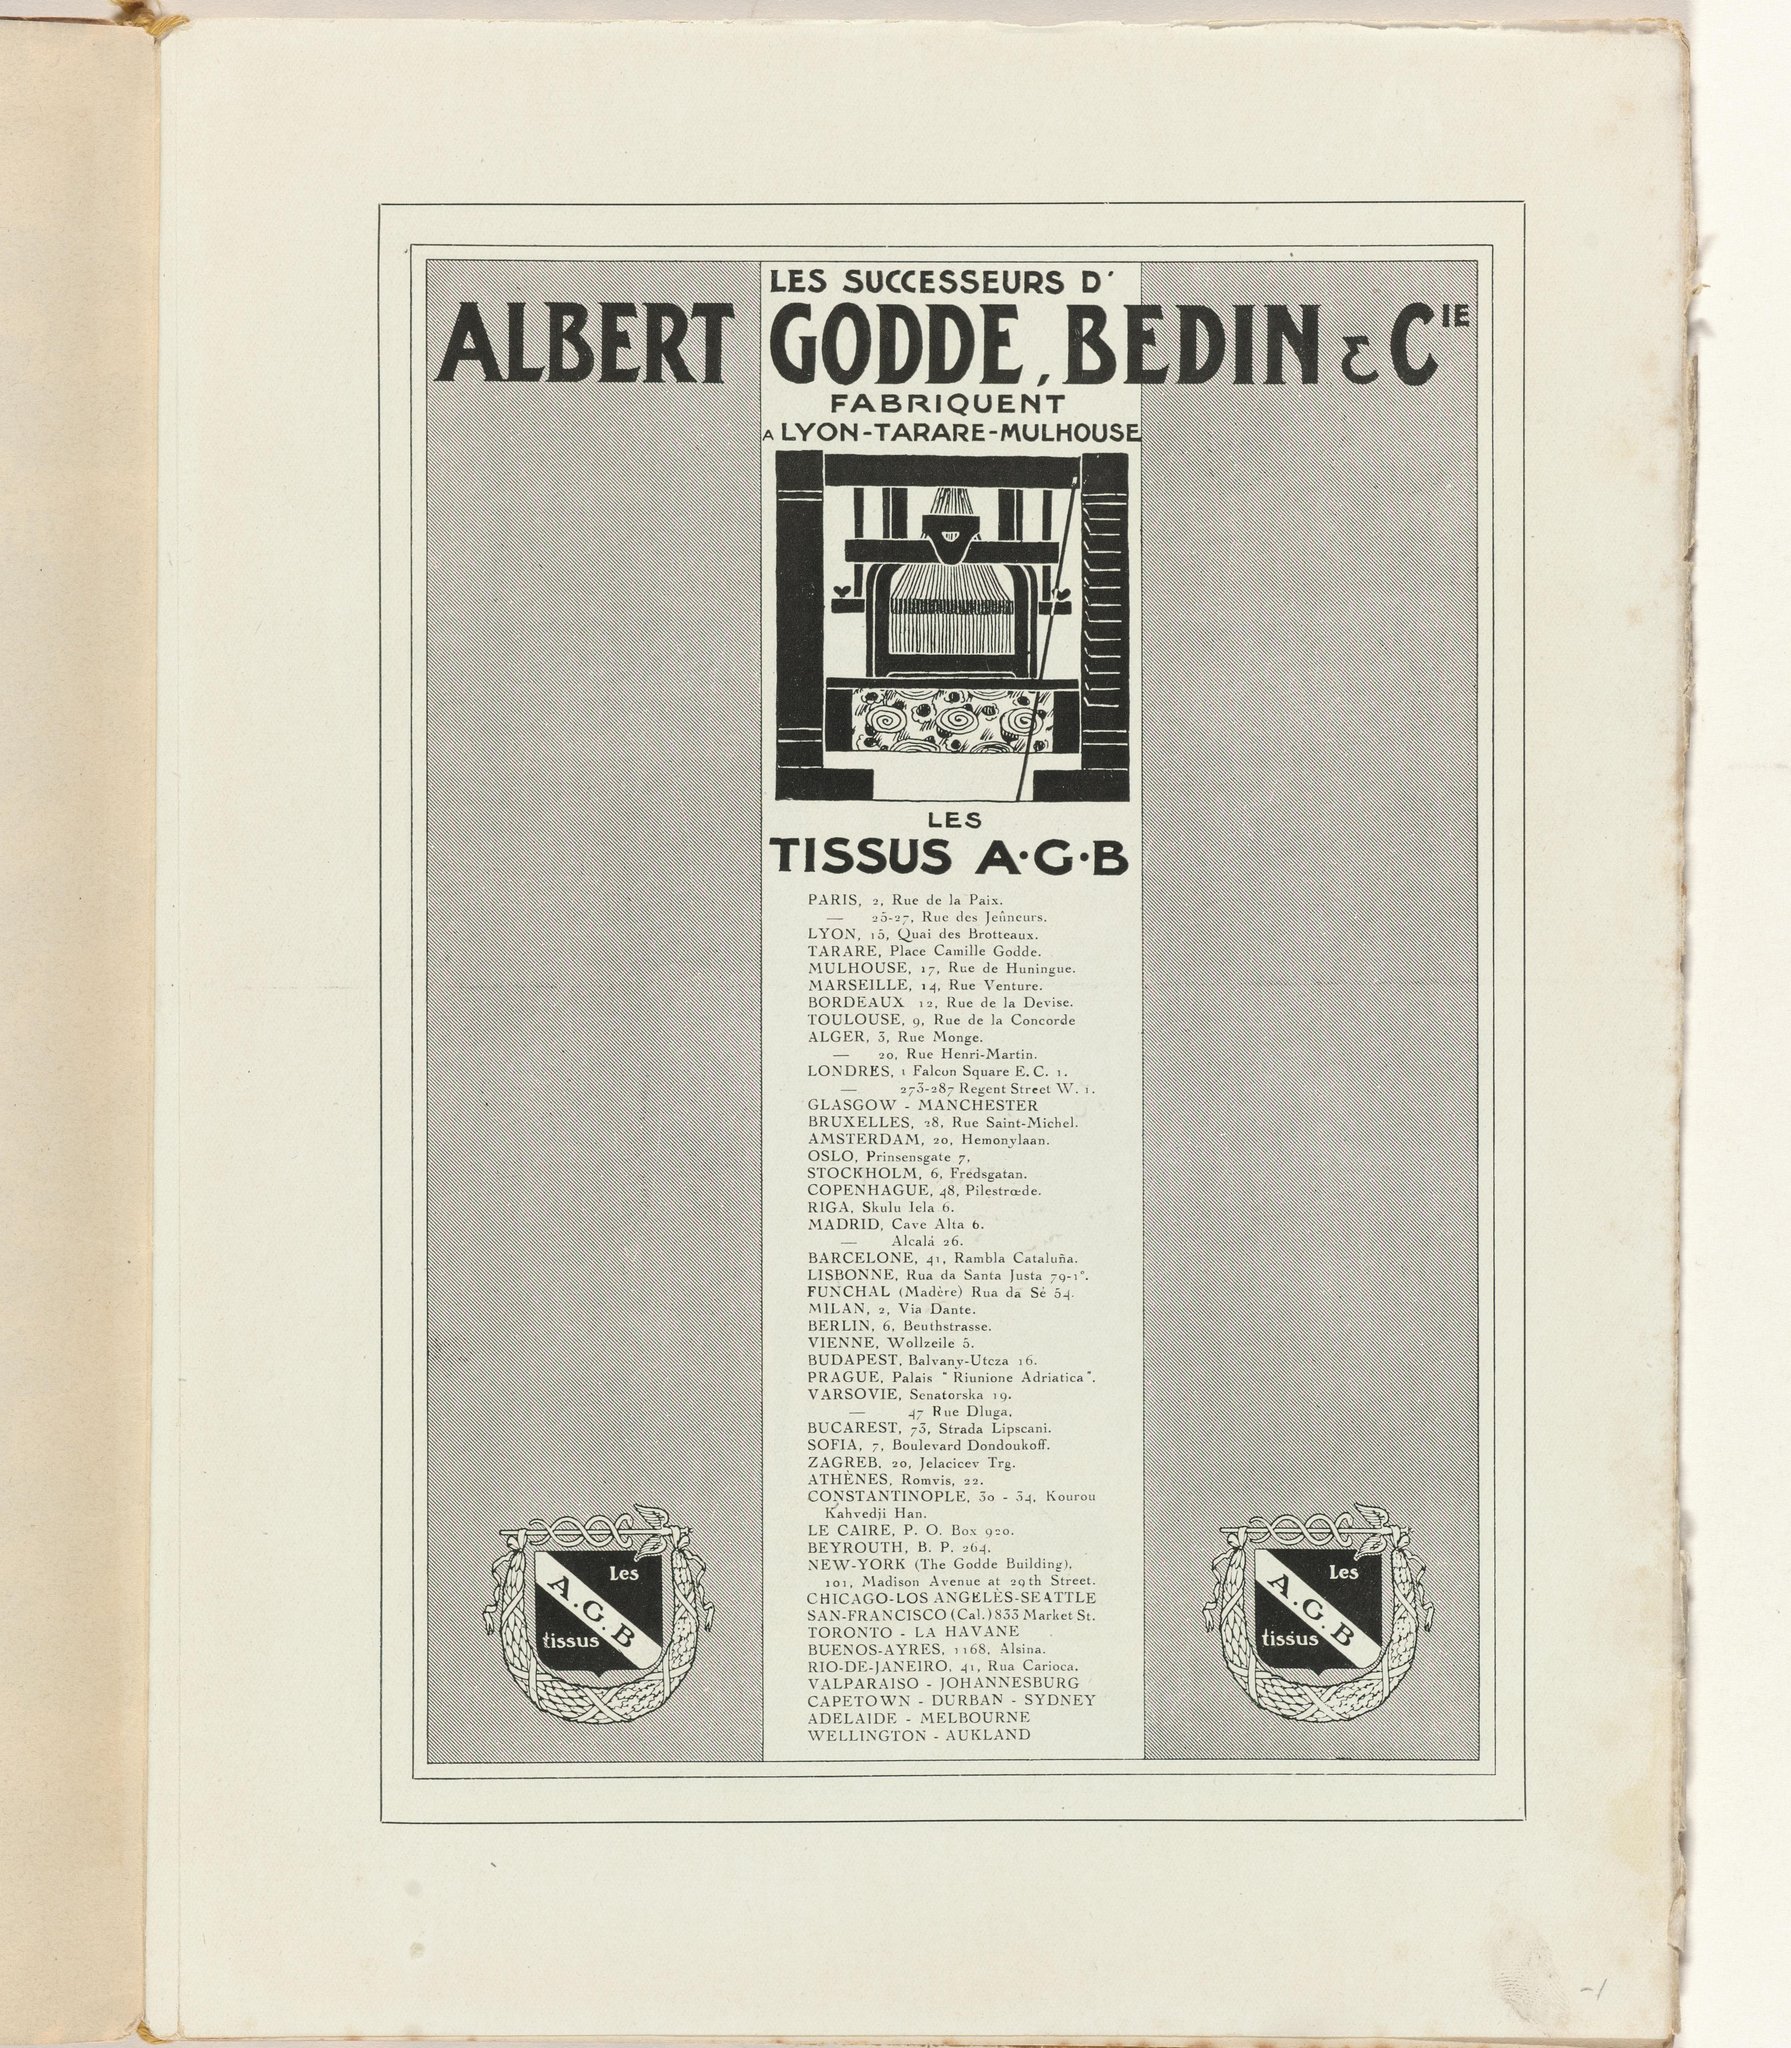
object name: magazine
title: Art - Goût - Beauté, Feuillets de l' élégance féminine, Novembre 1928, No. 99, 9e Année, p. 1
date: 1928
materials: paper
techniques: photography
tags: fashion plates, weaving-loom, textile fabric, cloth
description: Advertentie voor stoffen van de stoffenfabrikant ´Les Tissus A.G.B.´ ('Les successeurs d´Albert Godde, Bedin & Cie'). Pagina uit het modetijdschrift Art-Goût-Beauté (1920-1933).